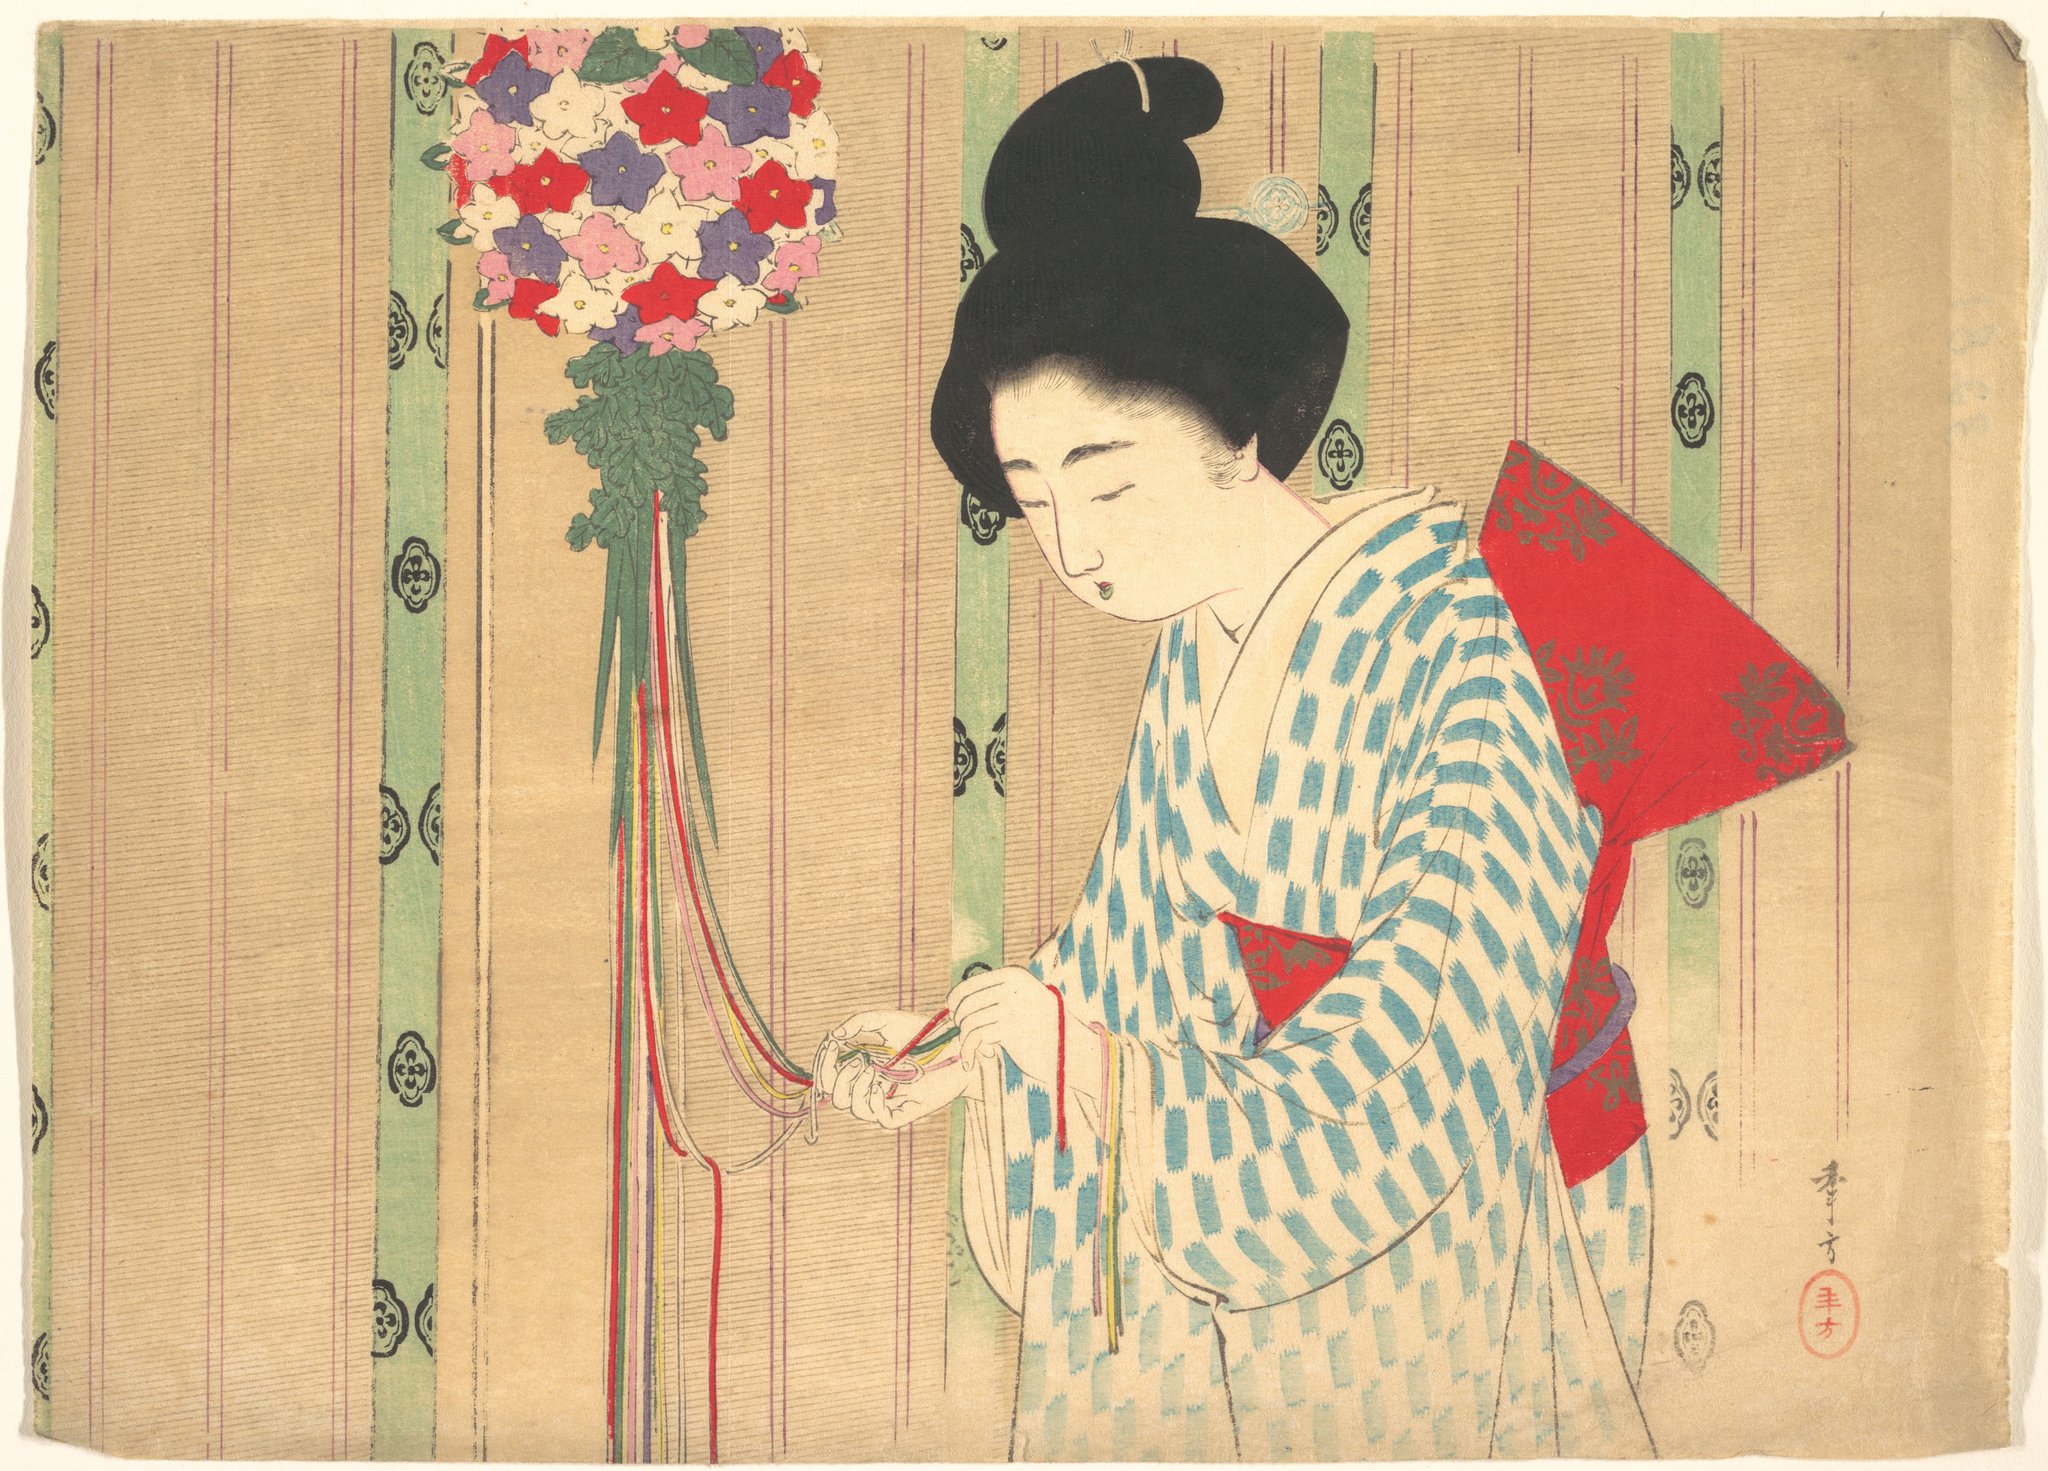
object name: print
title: Ornament Ball from kuchie (frontispiece) of a novel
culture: japanese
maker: mizuno toshikata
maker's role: artist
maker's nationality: japanese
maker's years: 1866-1908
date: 1906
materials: ink, paper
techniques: woodblock print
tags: women,flowers